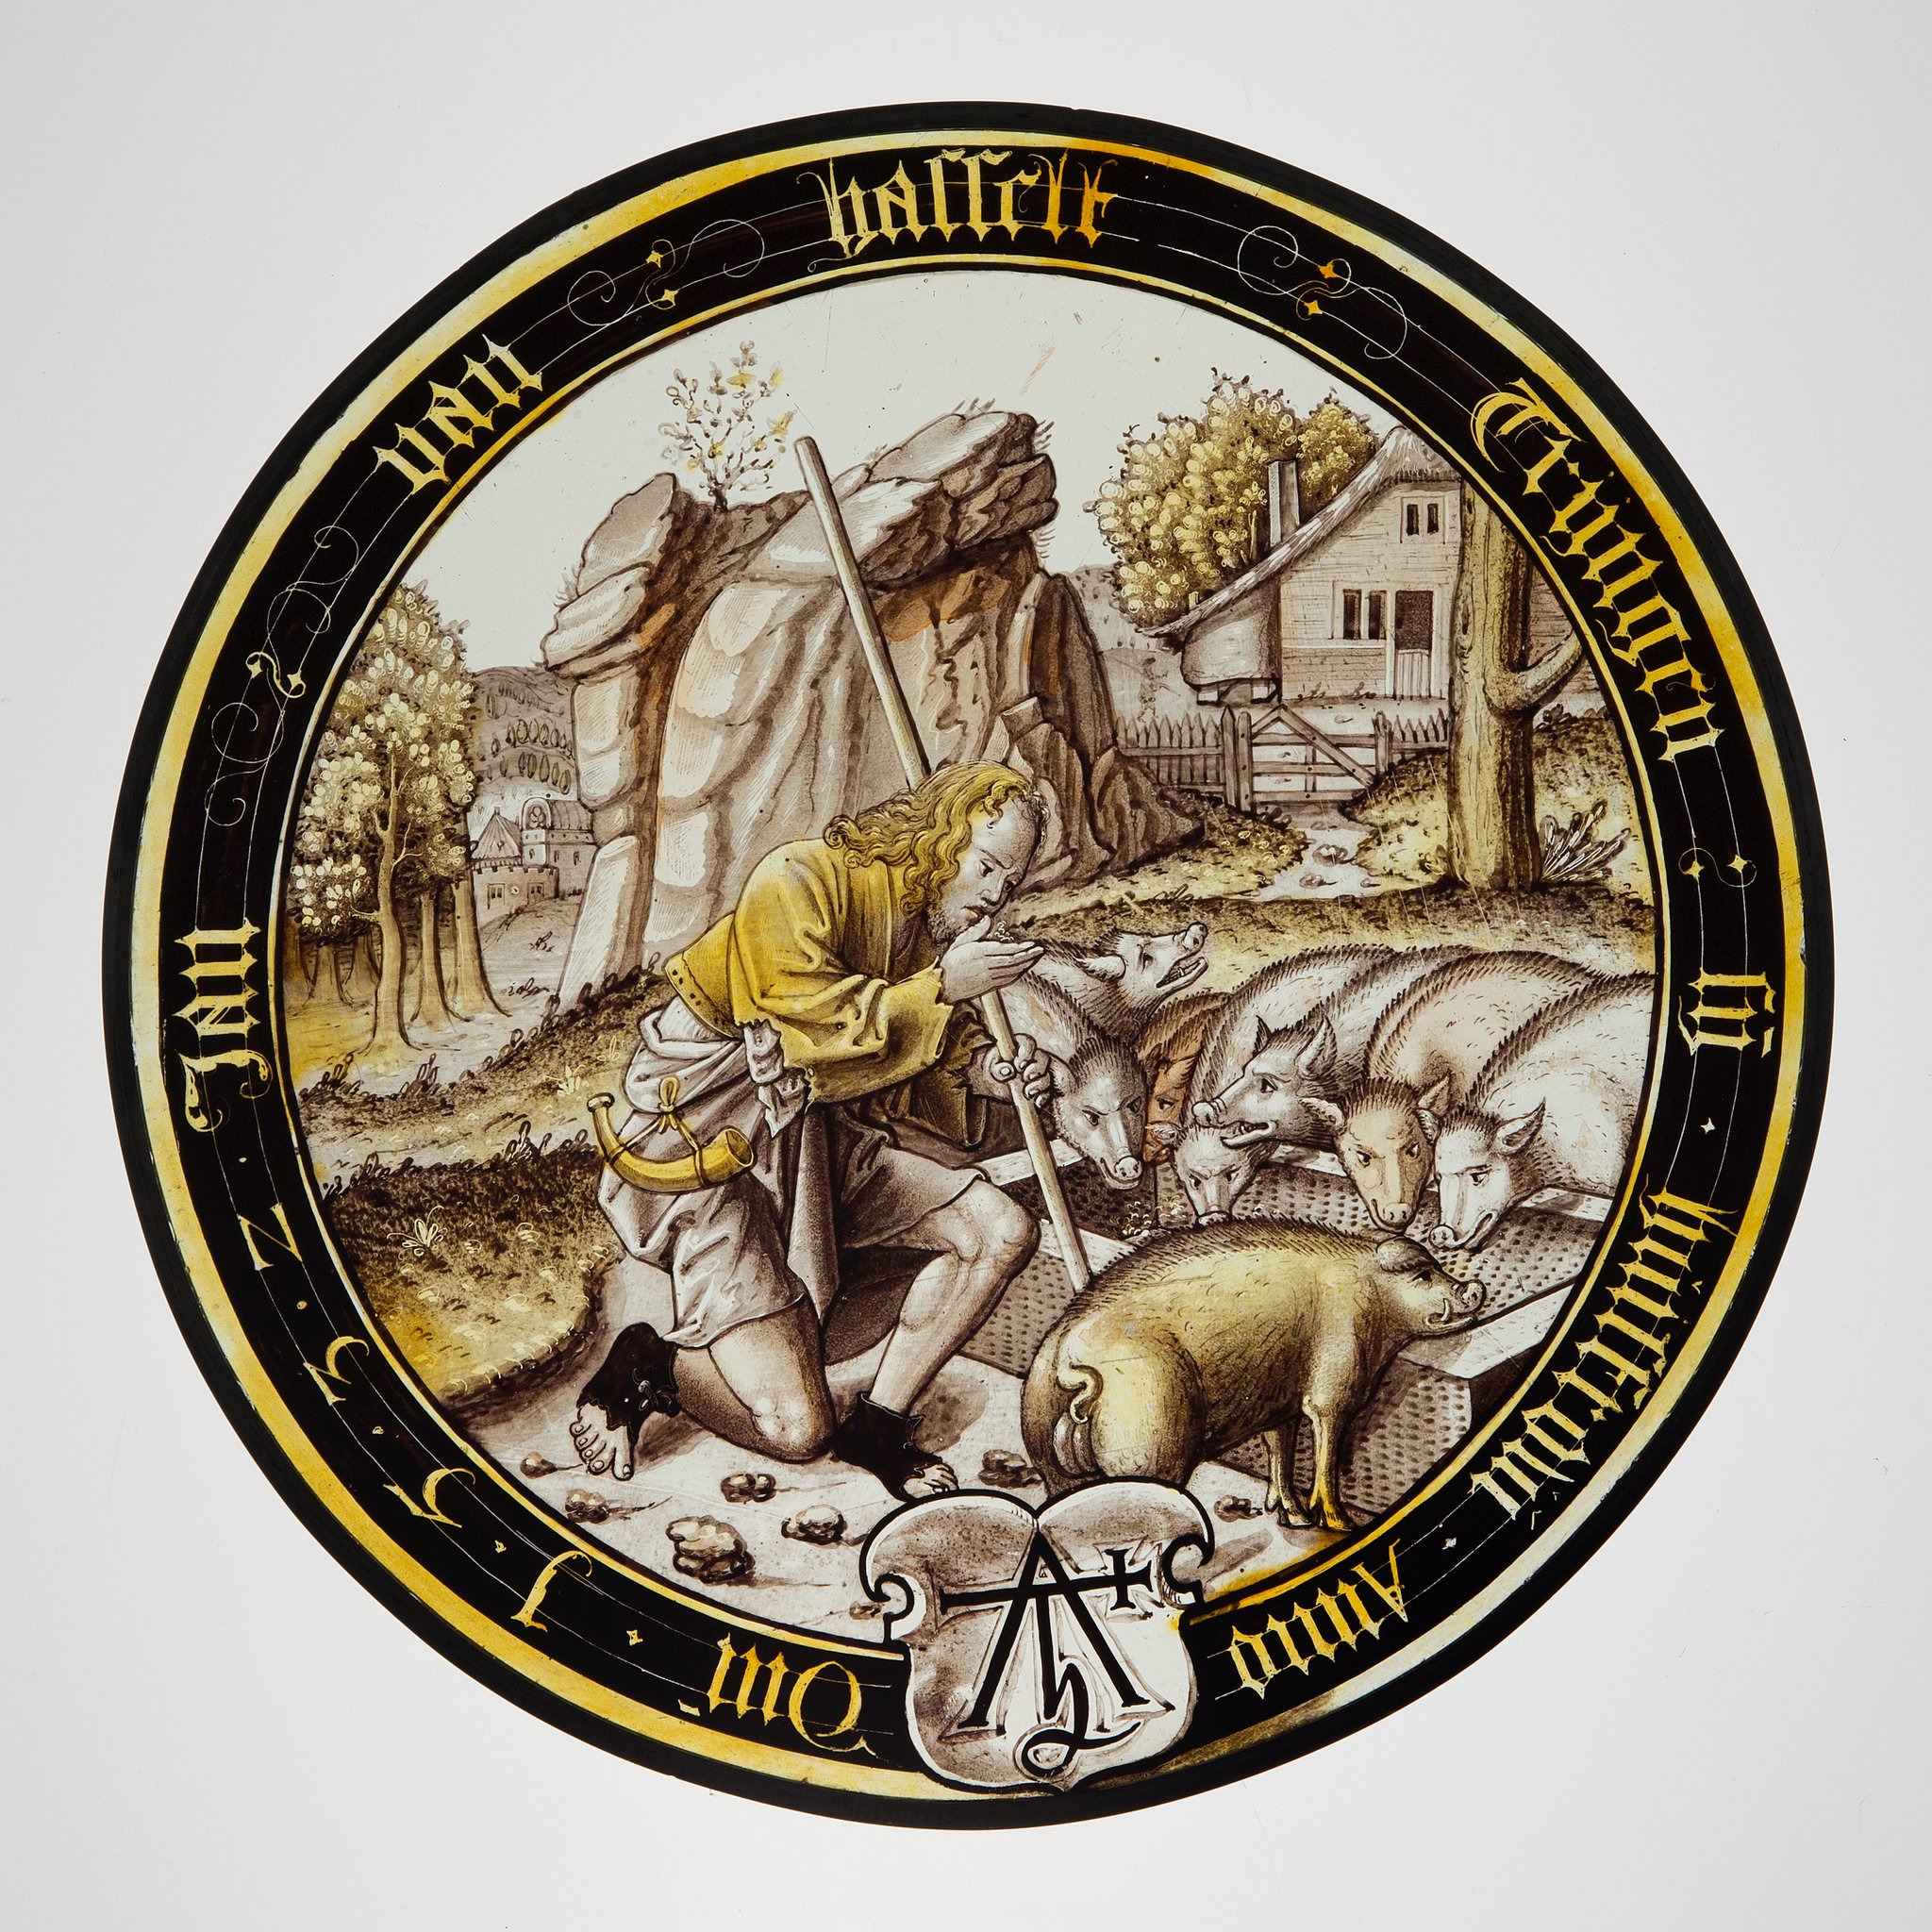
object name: roundel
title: The Prodigal as a Swineherd (one of eight scenes from the story of the Prodigal Son)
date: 1532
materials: glass, paint, pigment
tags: houses,men,boars,trees,insignia